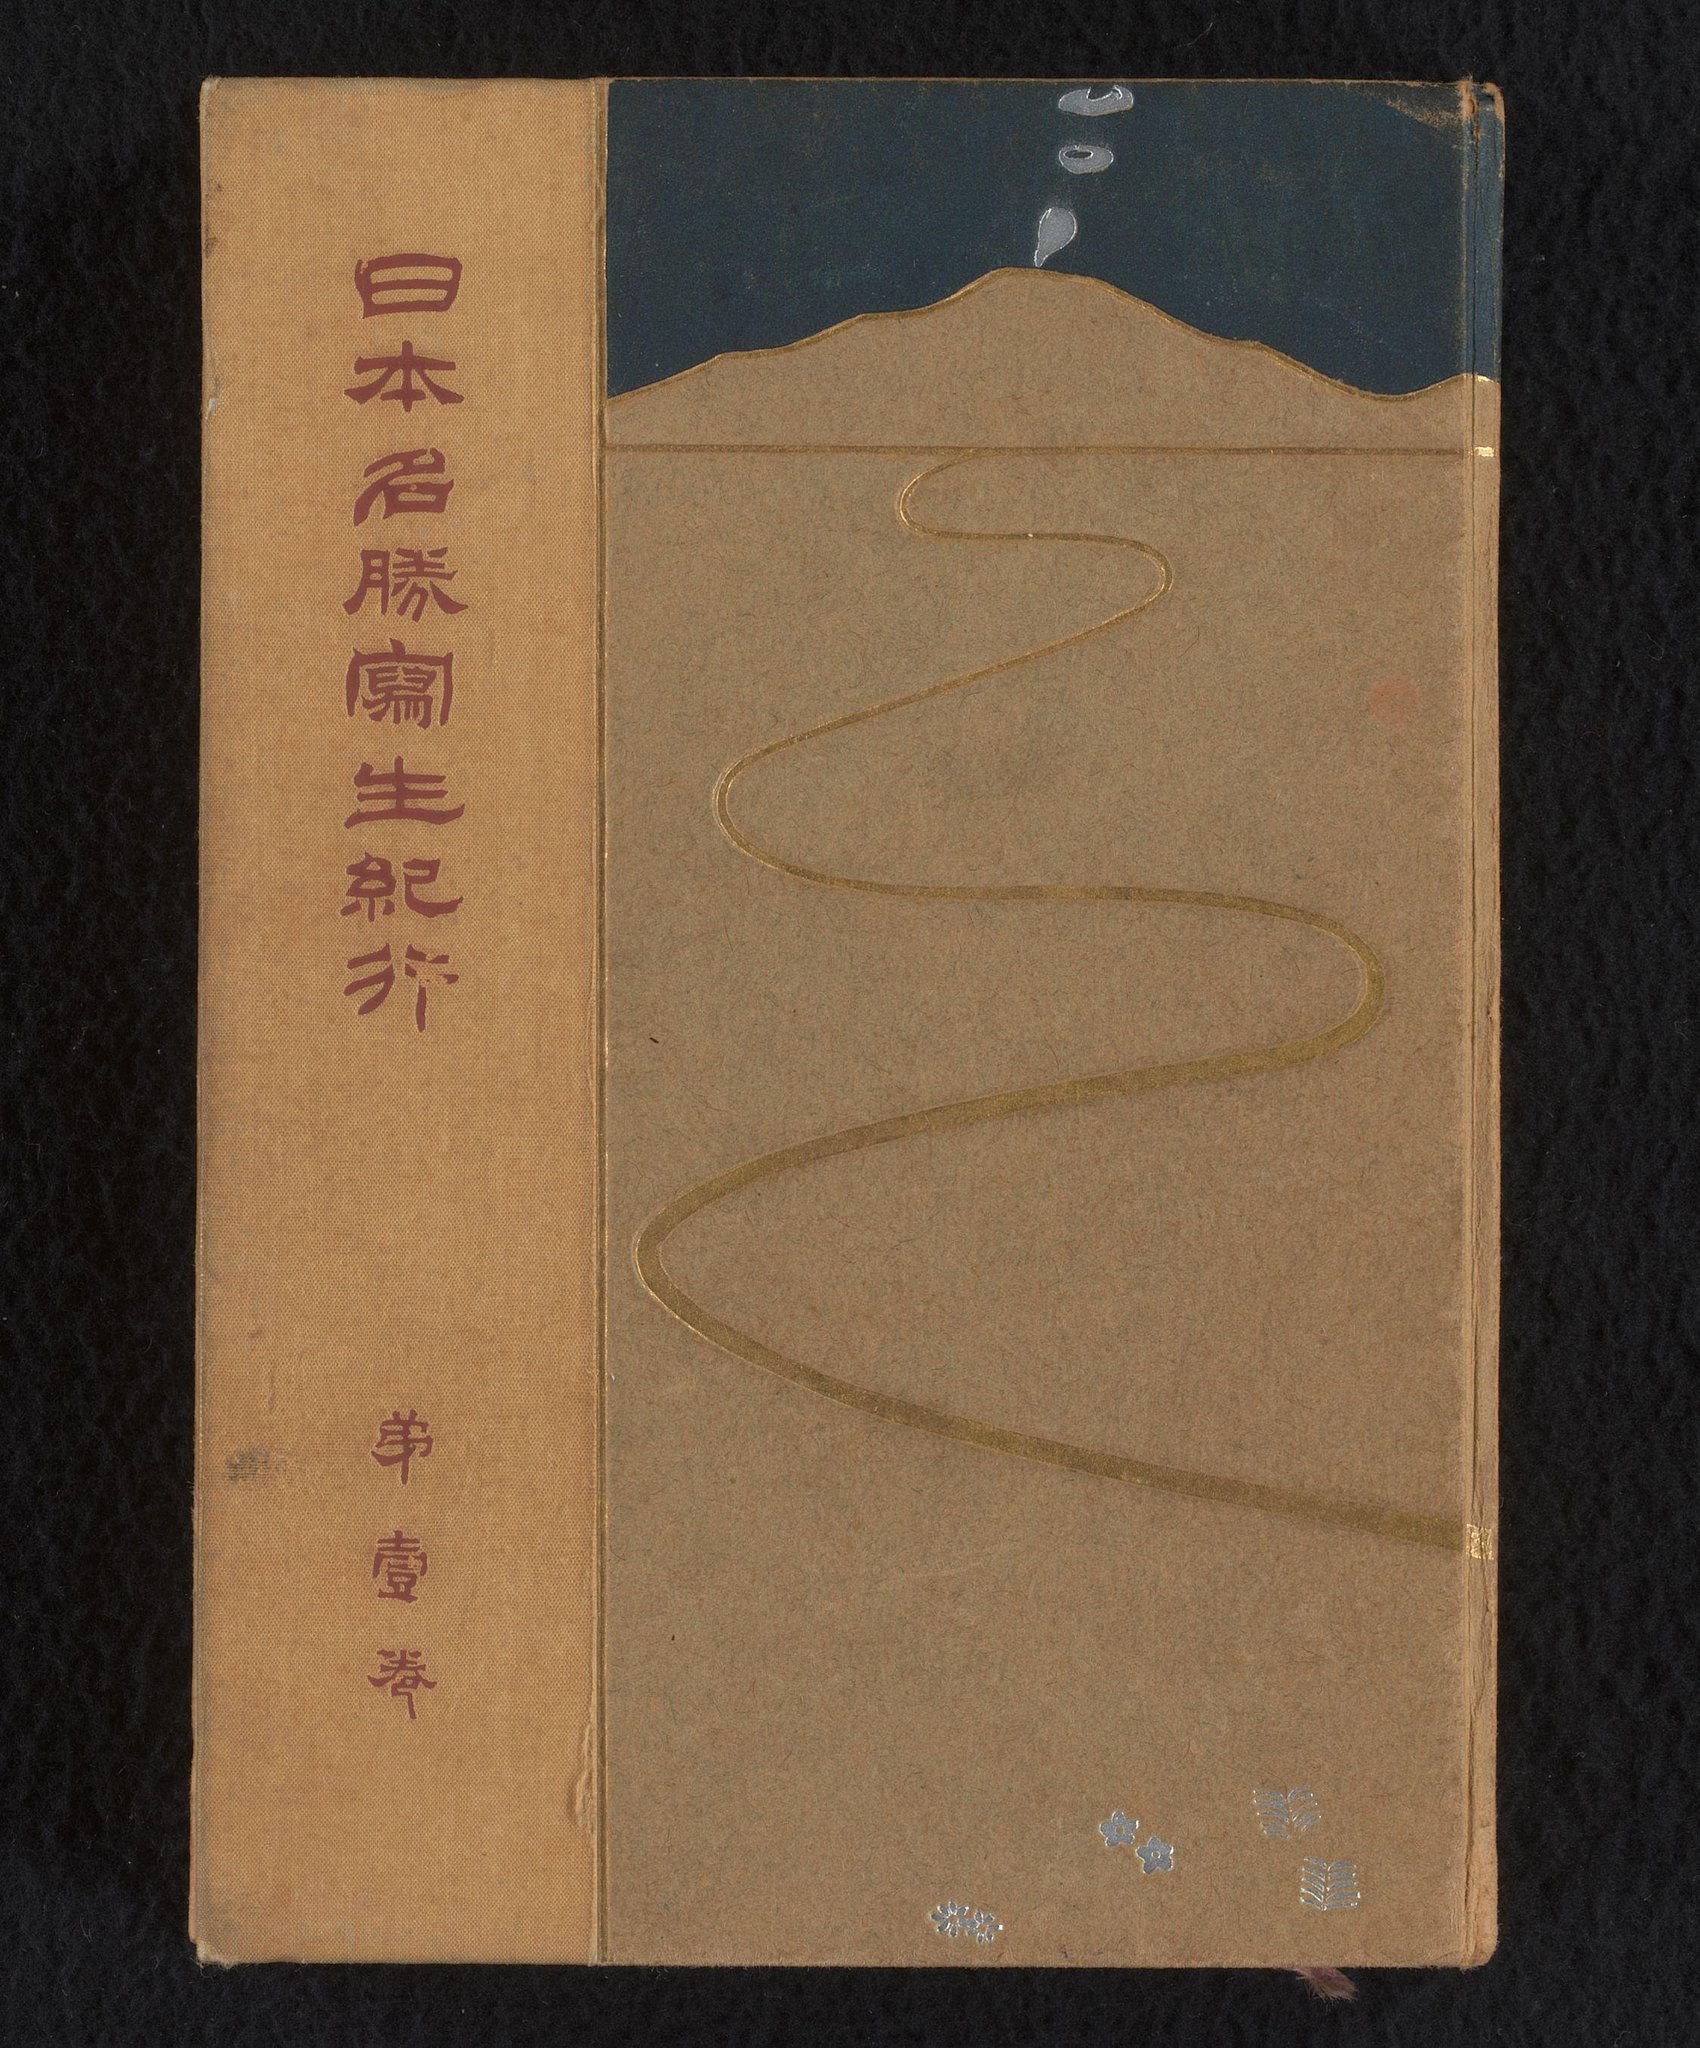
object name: book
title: Nihon meishô shasei kikô - dai isshû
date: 1909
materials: paper